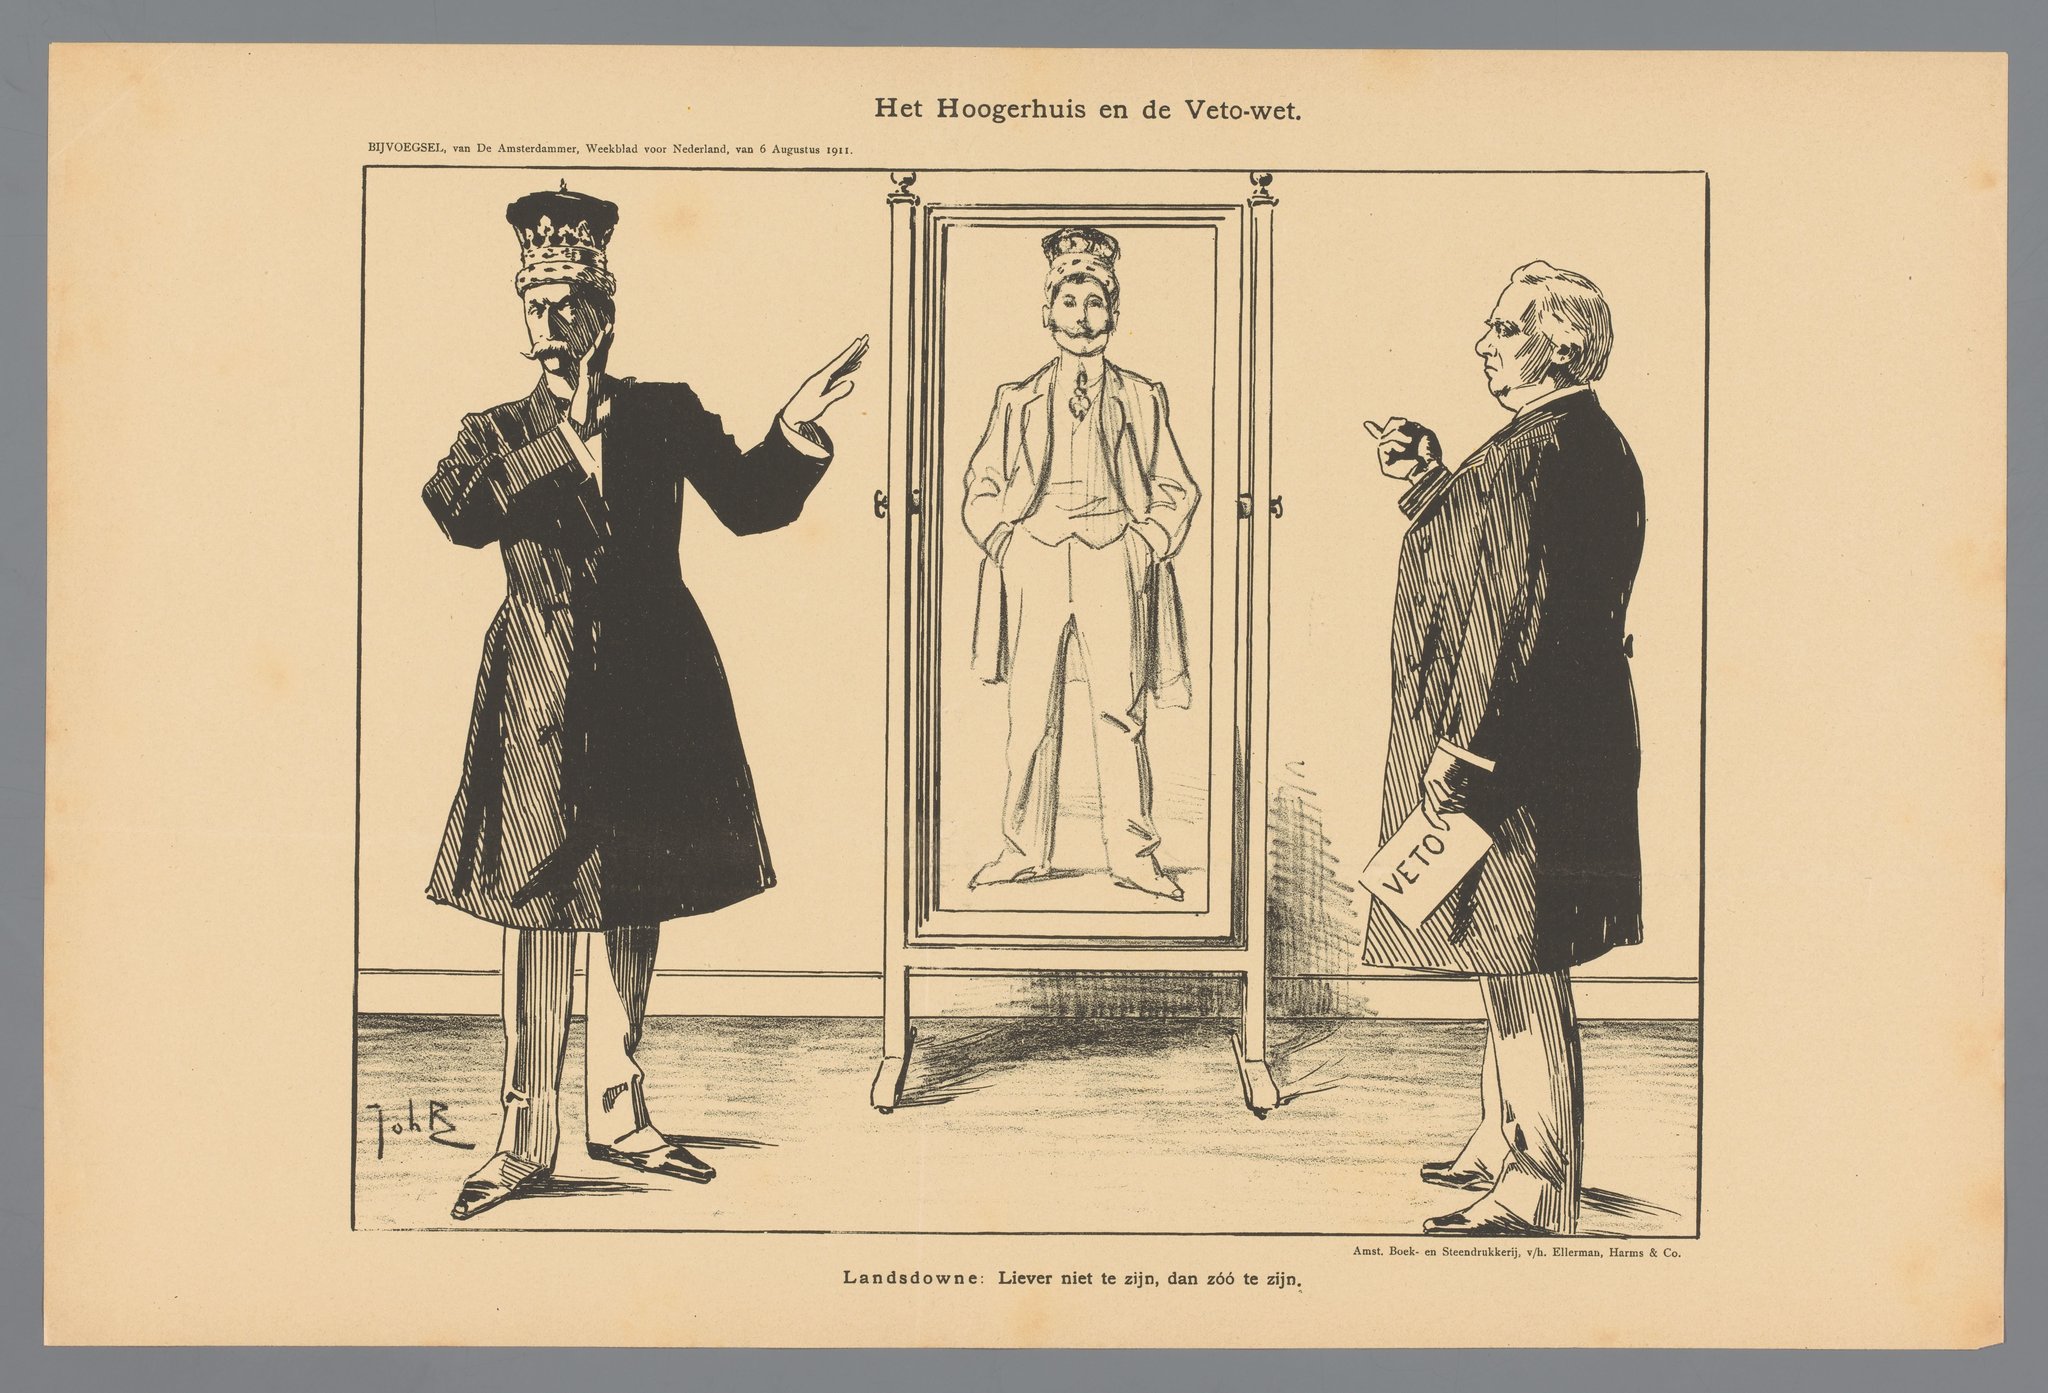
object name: cartoon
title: Het Hoogerhuis en de Veto-wet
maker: johan braakensiek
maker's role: draughtsman, print maker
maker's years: 1858-1940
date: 1911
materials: paper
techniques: lithograph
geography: amsterdam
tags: looking in the mirror; contemplation of own beauty, political caricatures and satires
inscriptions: date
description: Prent uit het bijvoegsel van: De Amsterdammer. Weekblad voor Nederland, 6 augustus 1911.